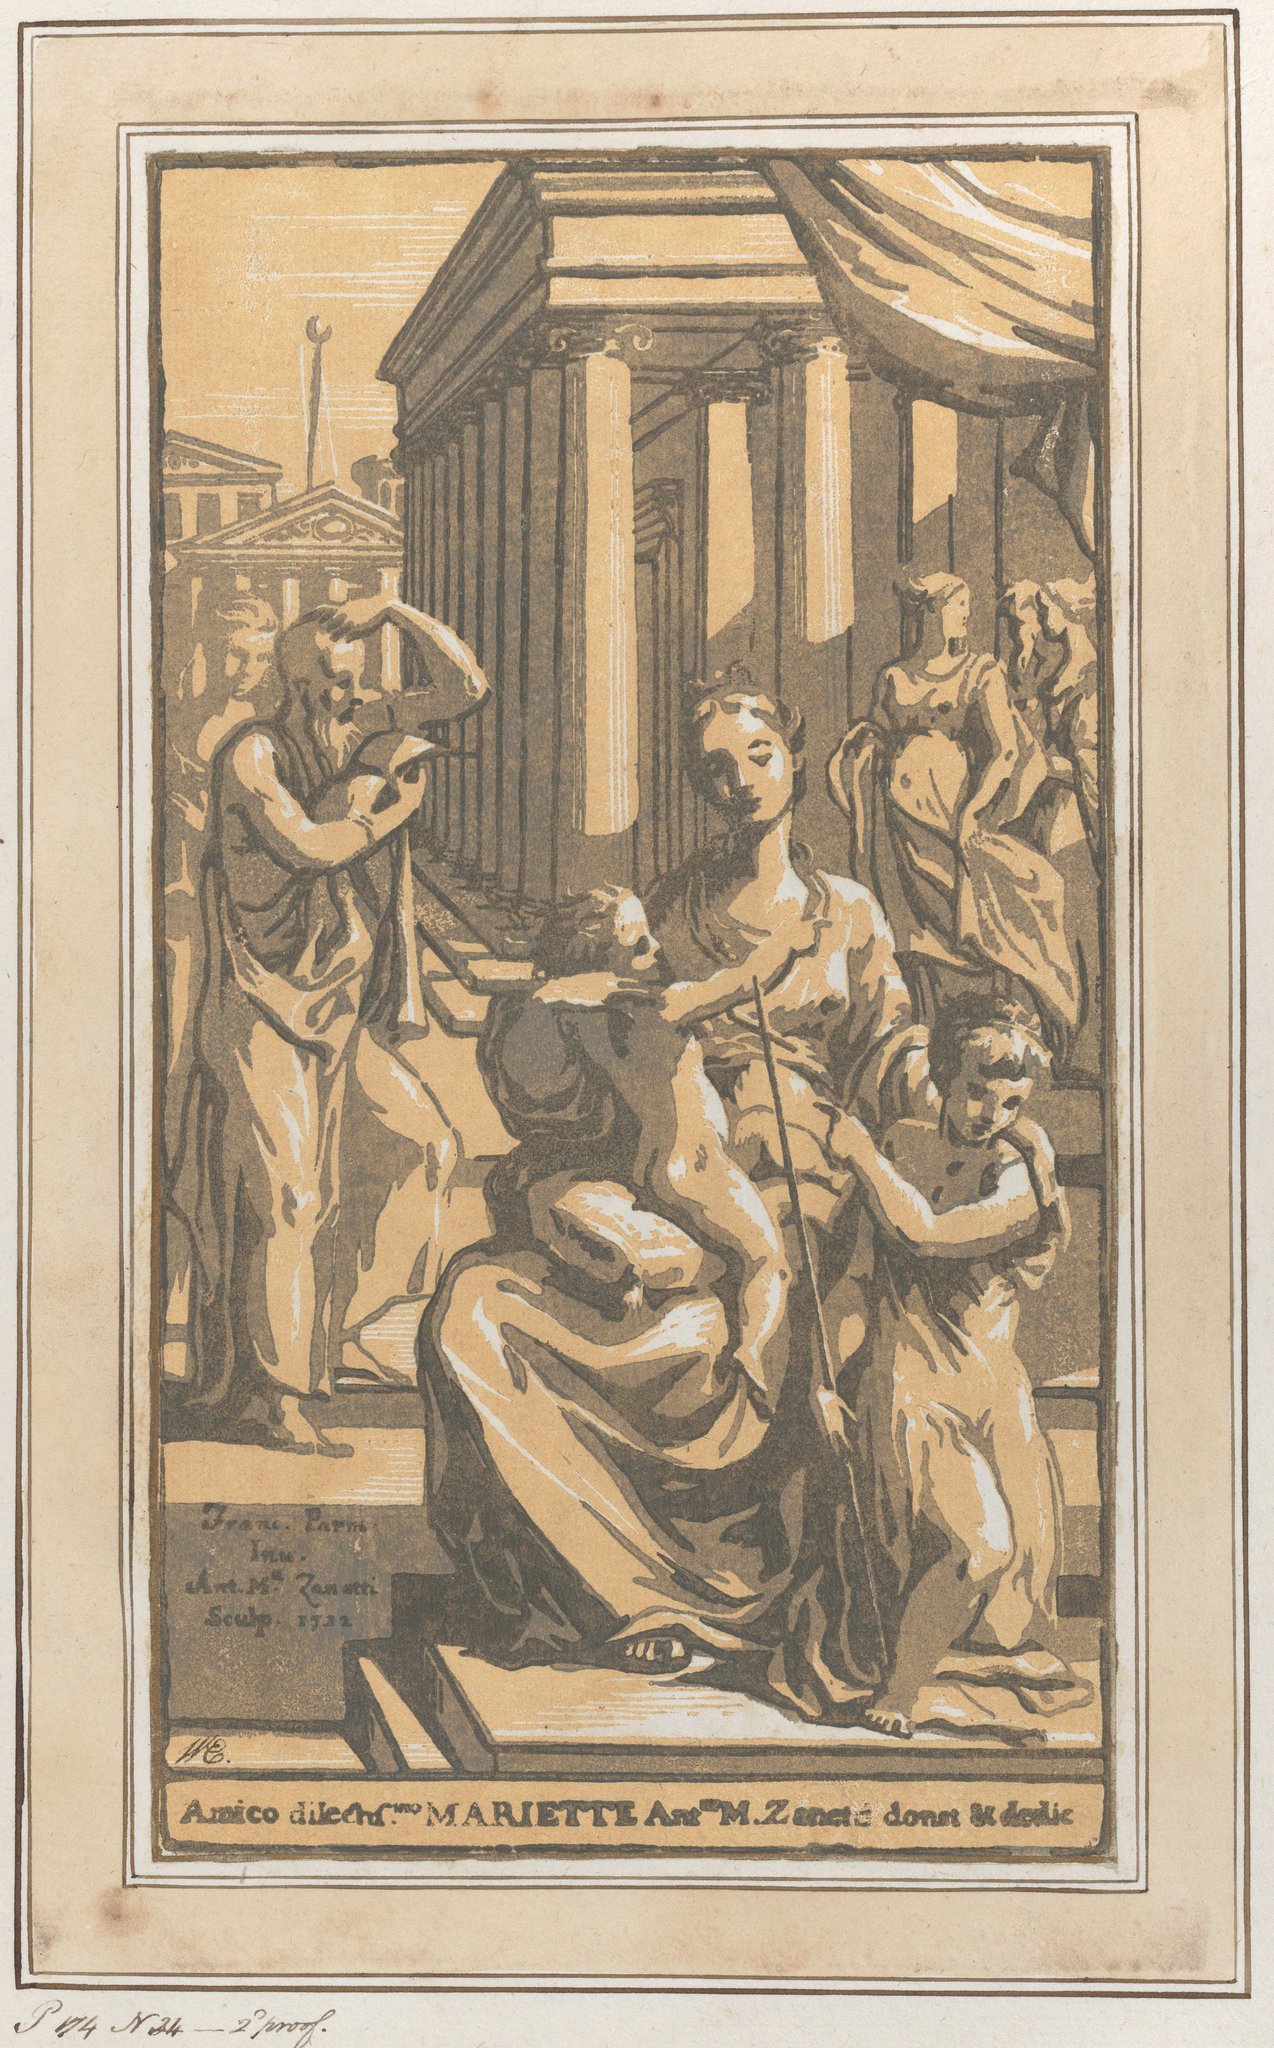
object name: print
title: The Virgin and Child with Saint John the Baptist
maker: conte anton maria zanetti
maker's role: artist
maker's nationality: italian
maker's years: 1680-1767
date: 1722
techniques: woodcut, line block